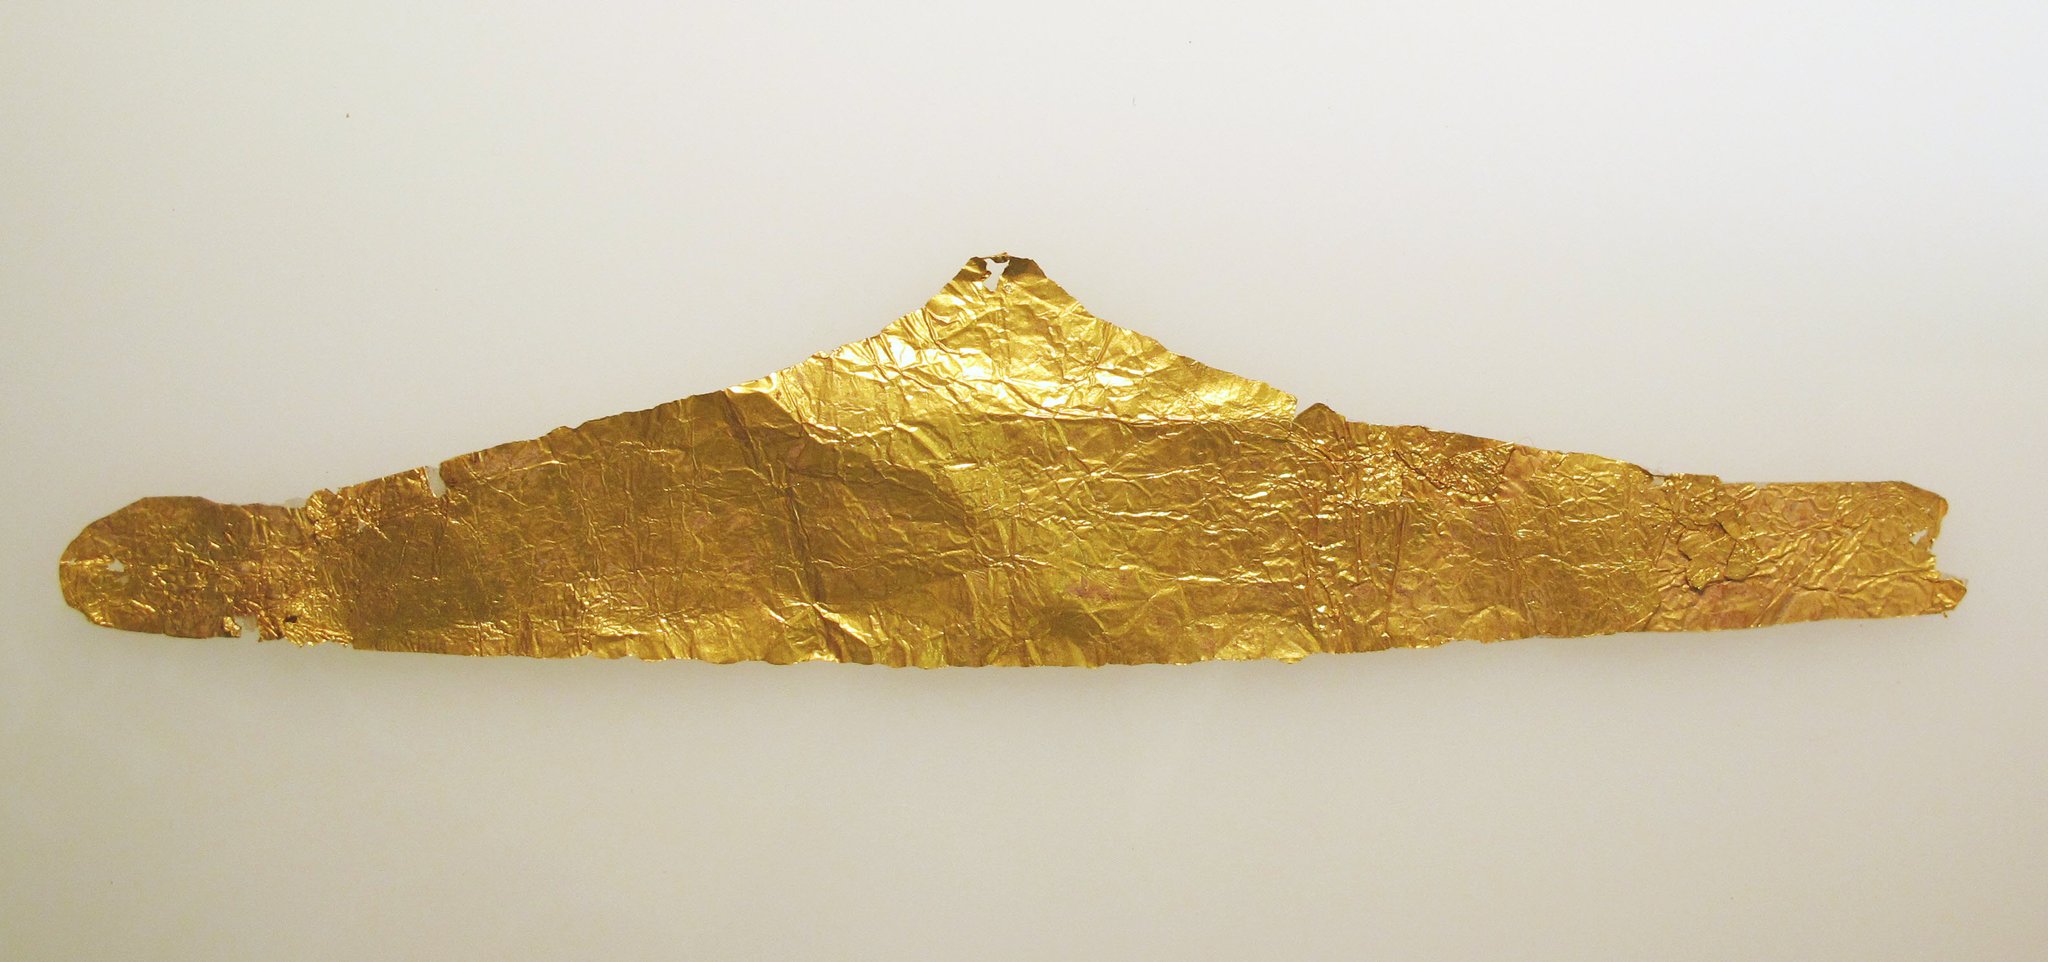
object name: frontlet of gold leaf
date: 7000 BCE-330 CE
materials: gold